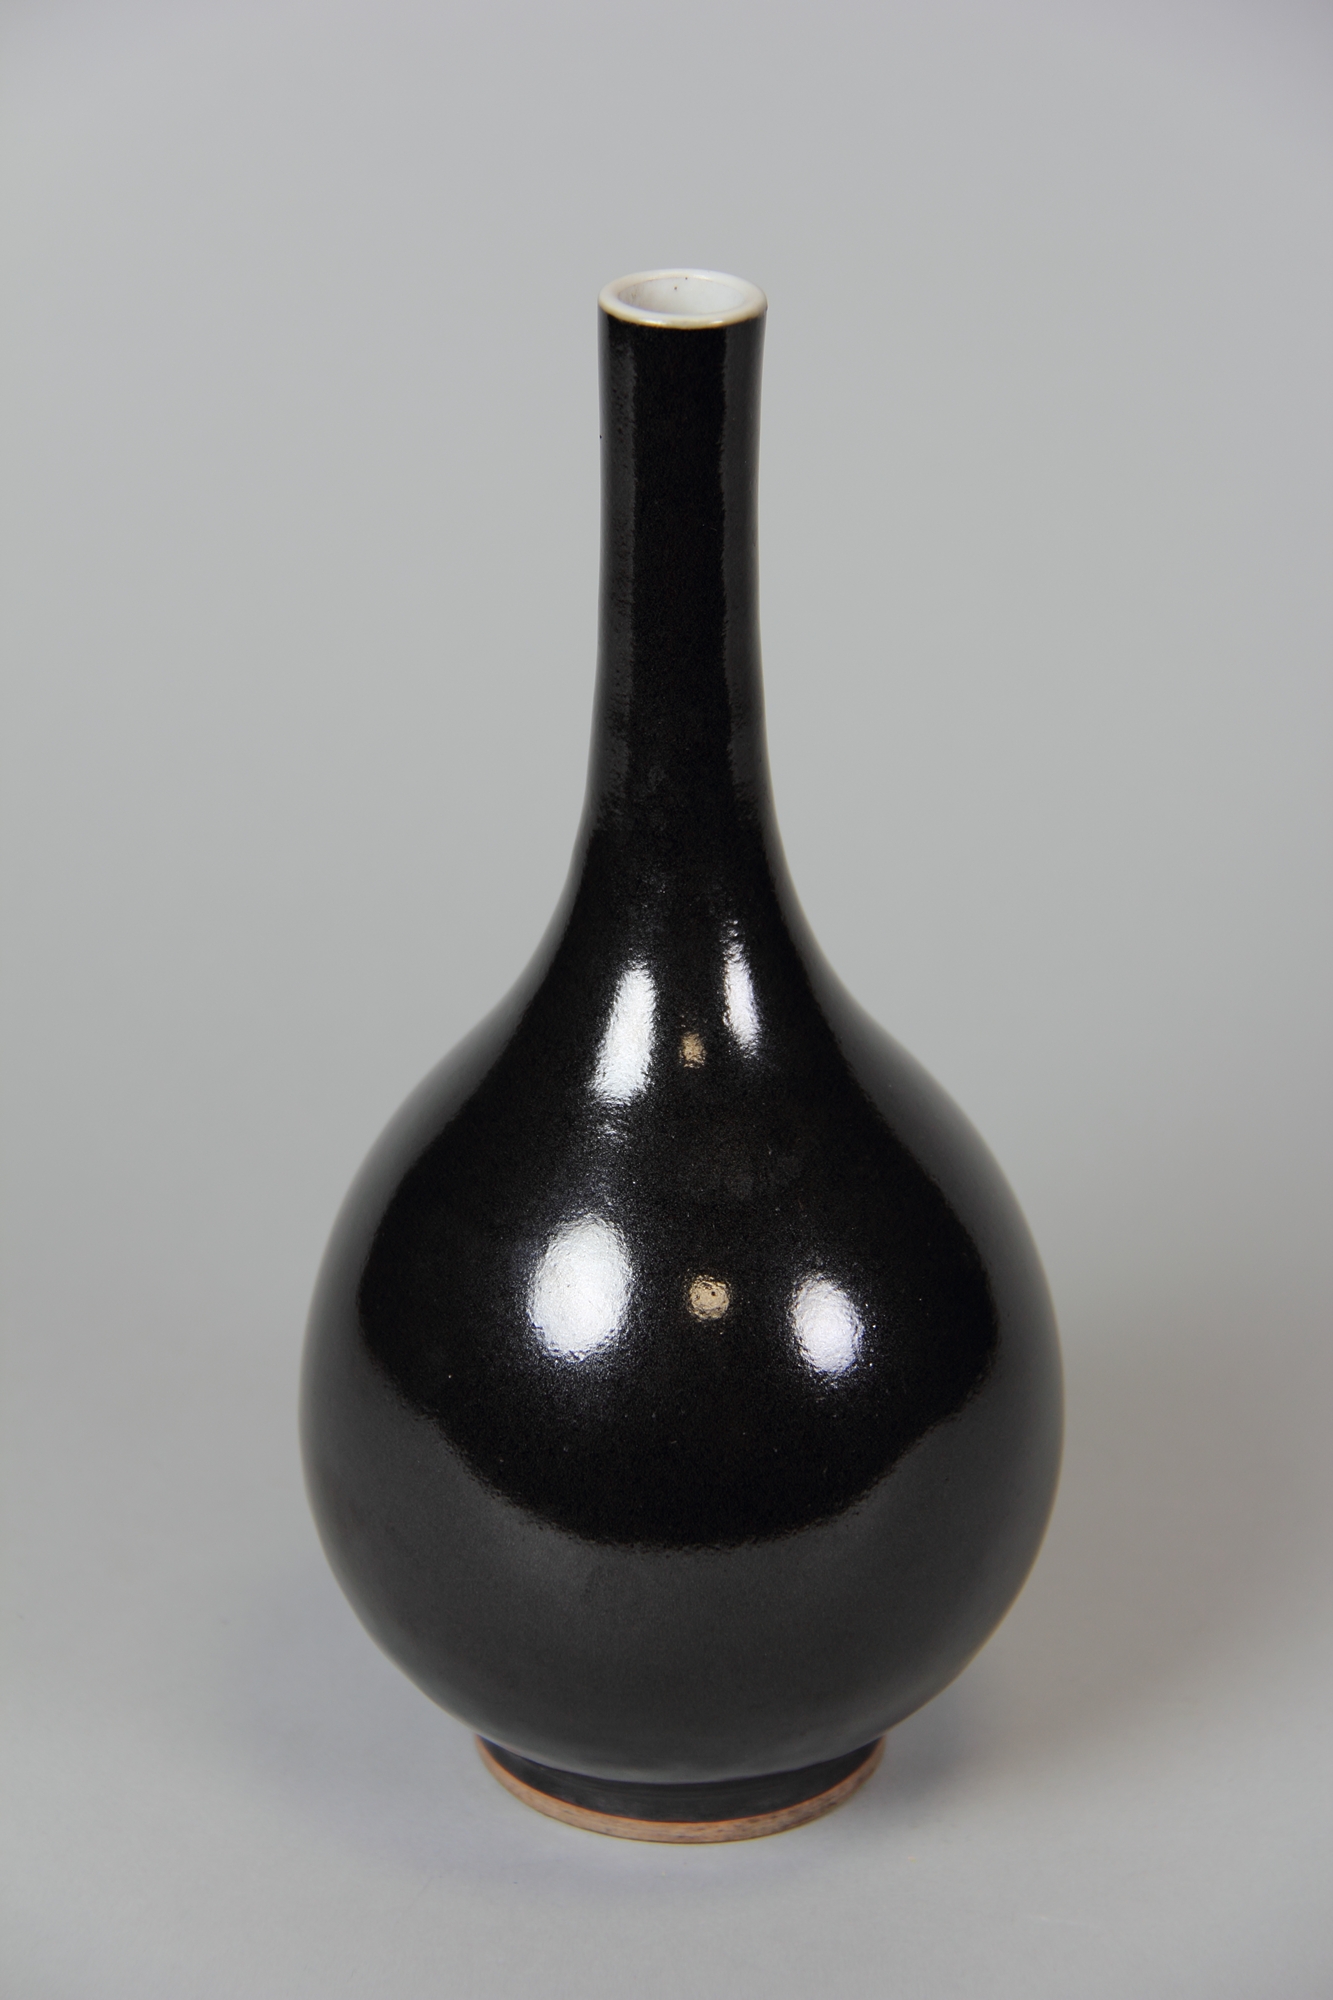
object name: bottle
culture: chinese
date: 1736-1795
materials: glaze, porcelain